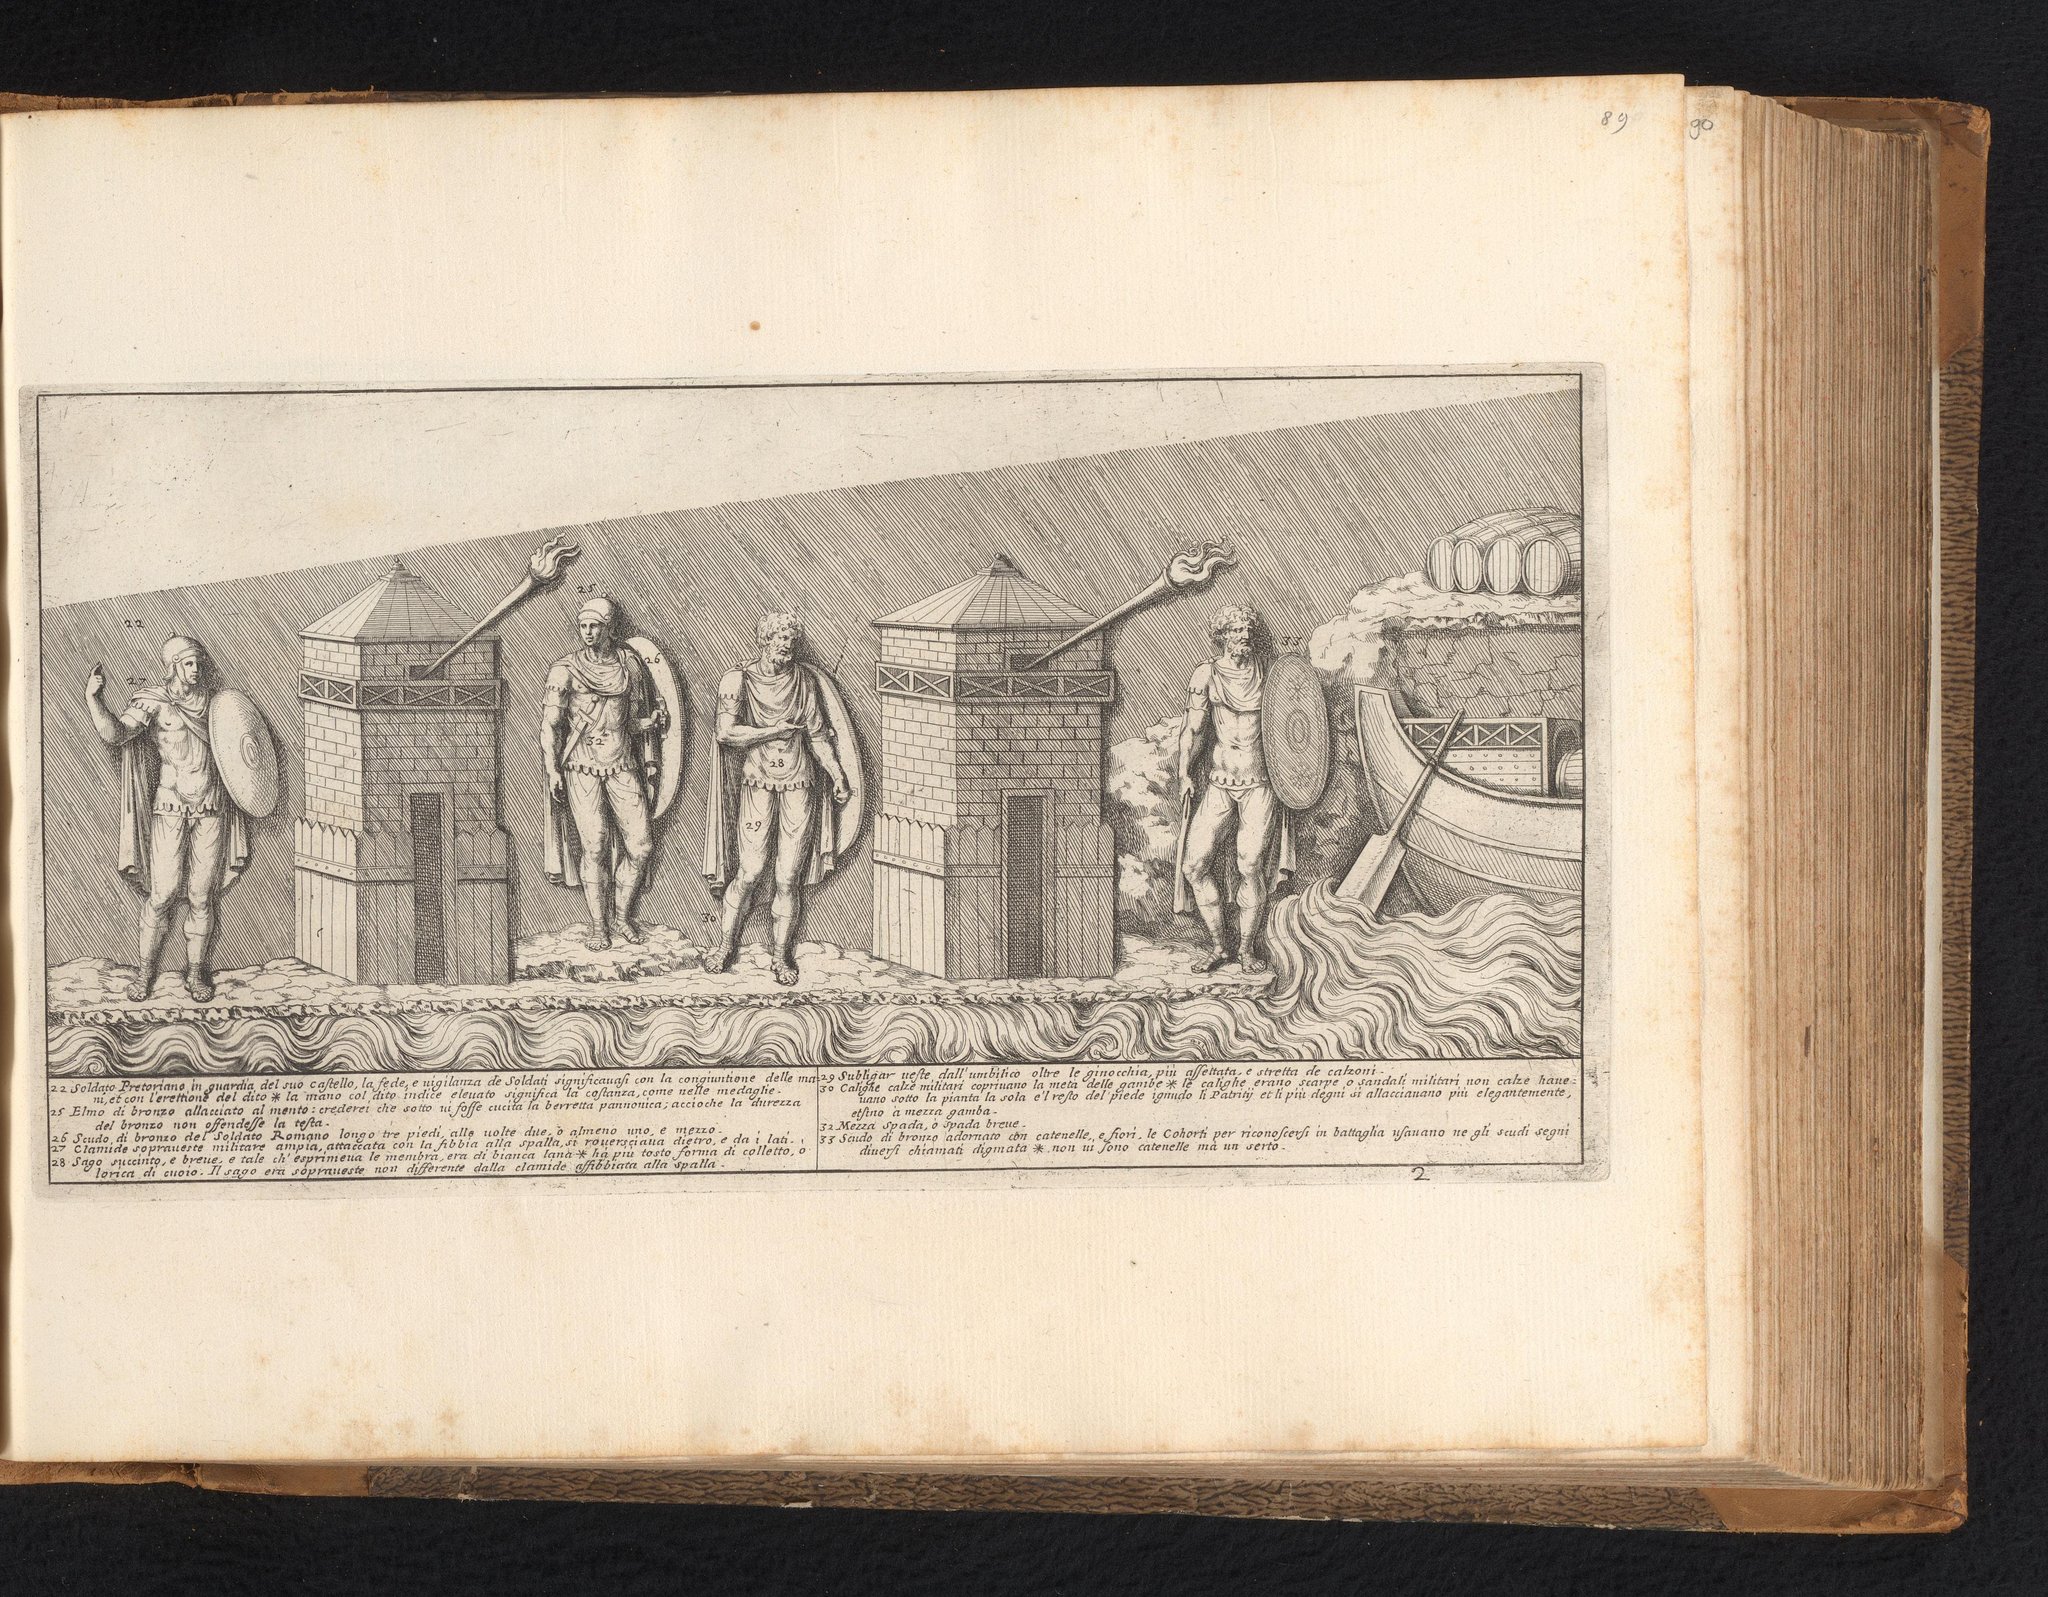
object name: album leaf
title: Zuil van Trajanus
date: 1637-1691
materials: paper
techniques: etching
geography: rome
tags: triumphal column with helical friezes, piece of sculpture, reproduction of a piece of sculpture, the soldier; the soldier's life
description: Detail van het spiraalvormige gebeeldhouwde fries op de Zuil van Trajanus. Het fries toont de oorlogen tussen de Romeinen en de Daciërs. Verklarende nummers in de ondermarge. Prent maakt deel uit van een album.